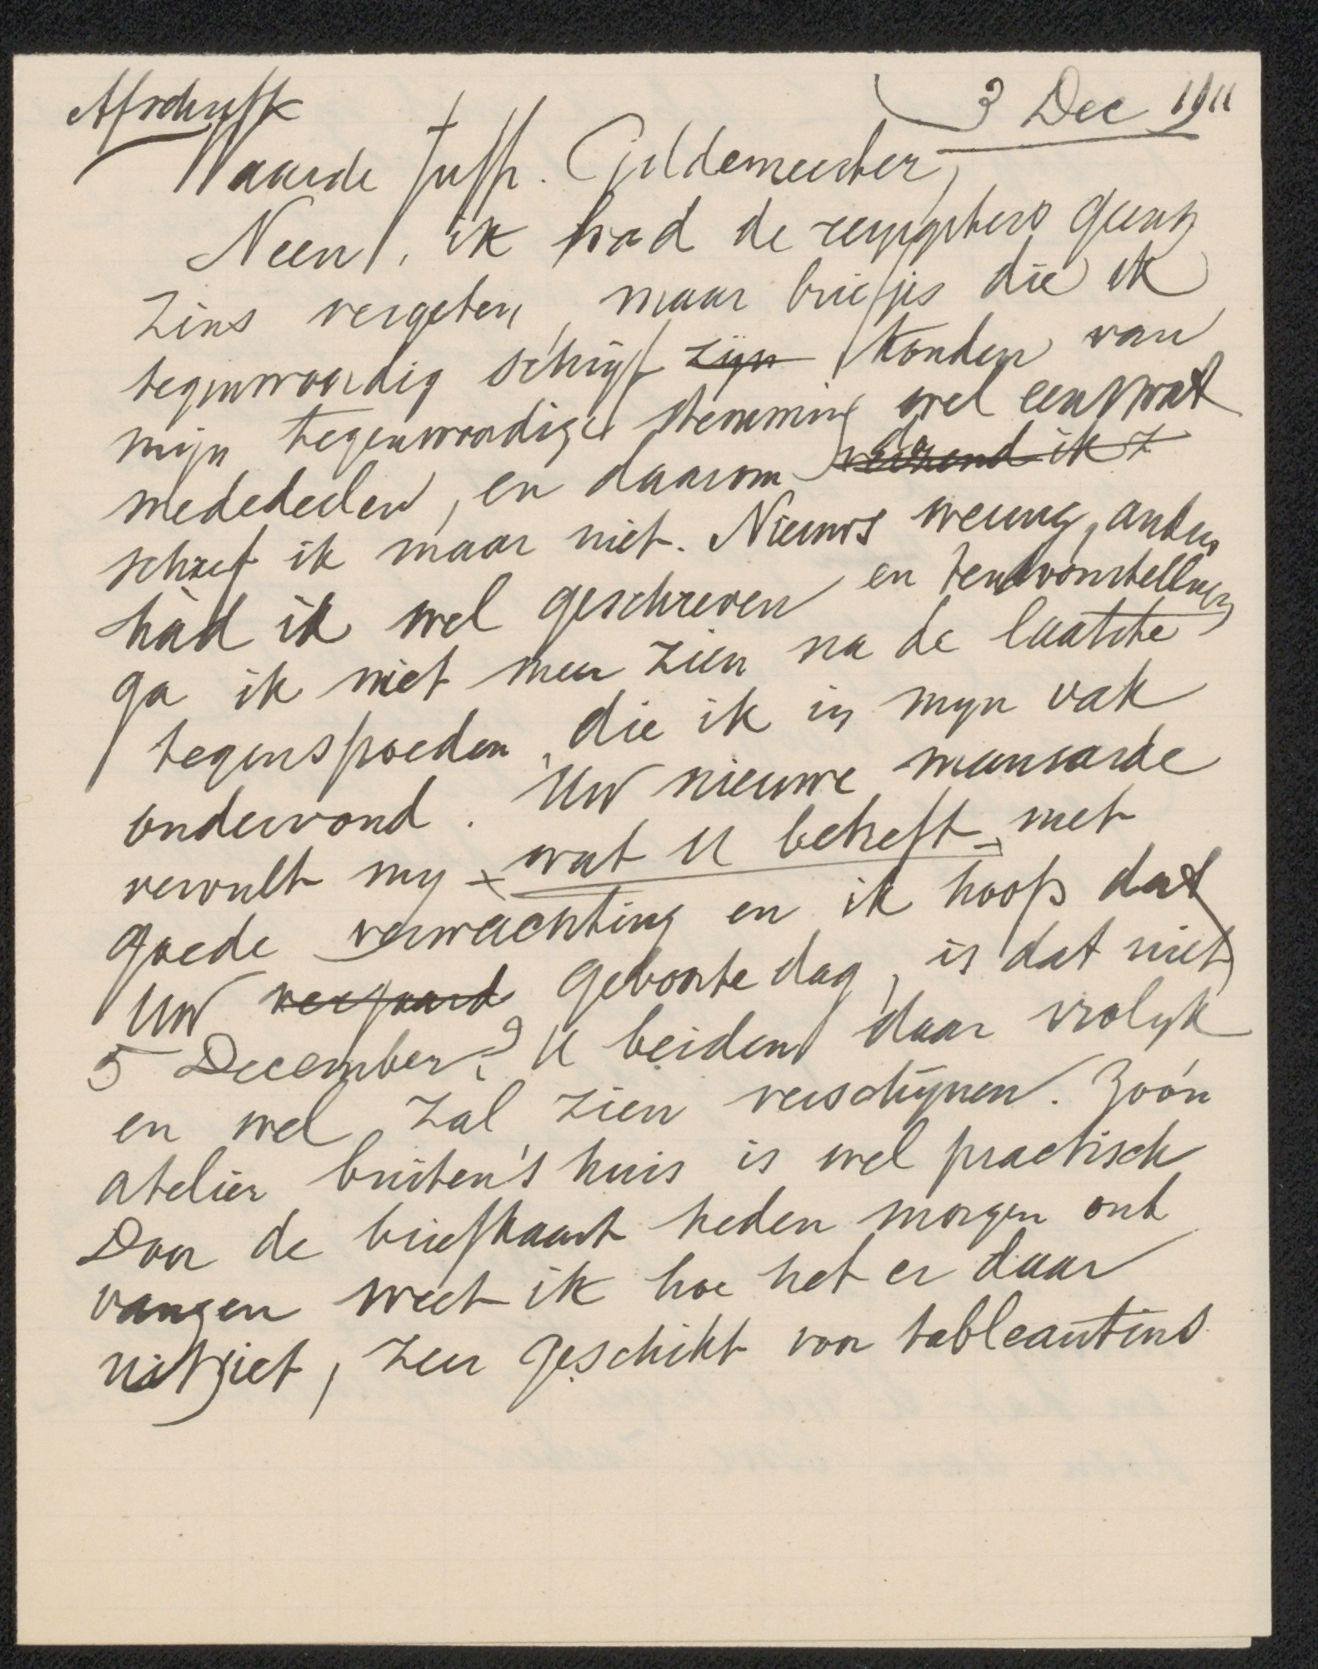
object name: letter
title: Brief aan Anna Gildemeester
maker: august allebé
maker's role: draughtsman, print maker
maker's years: 1838-1927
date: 1911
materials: ink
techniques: pen, writing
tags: antwerp, frans hals, rijksmuseum amsterdam, amsterdam, painter, draughtsman, workshop, studio of the artist (in general), exhibition ~ art